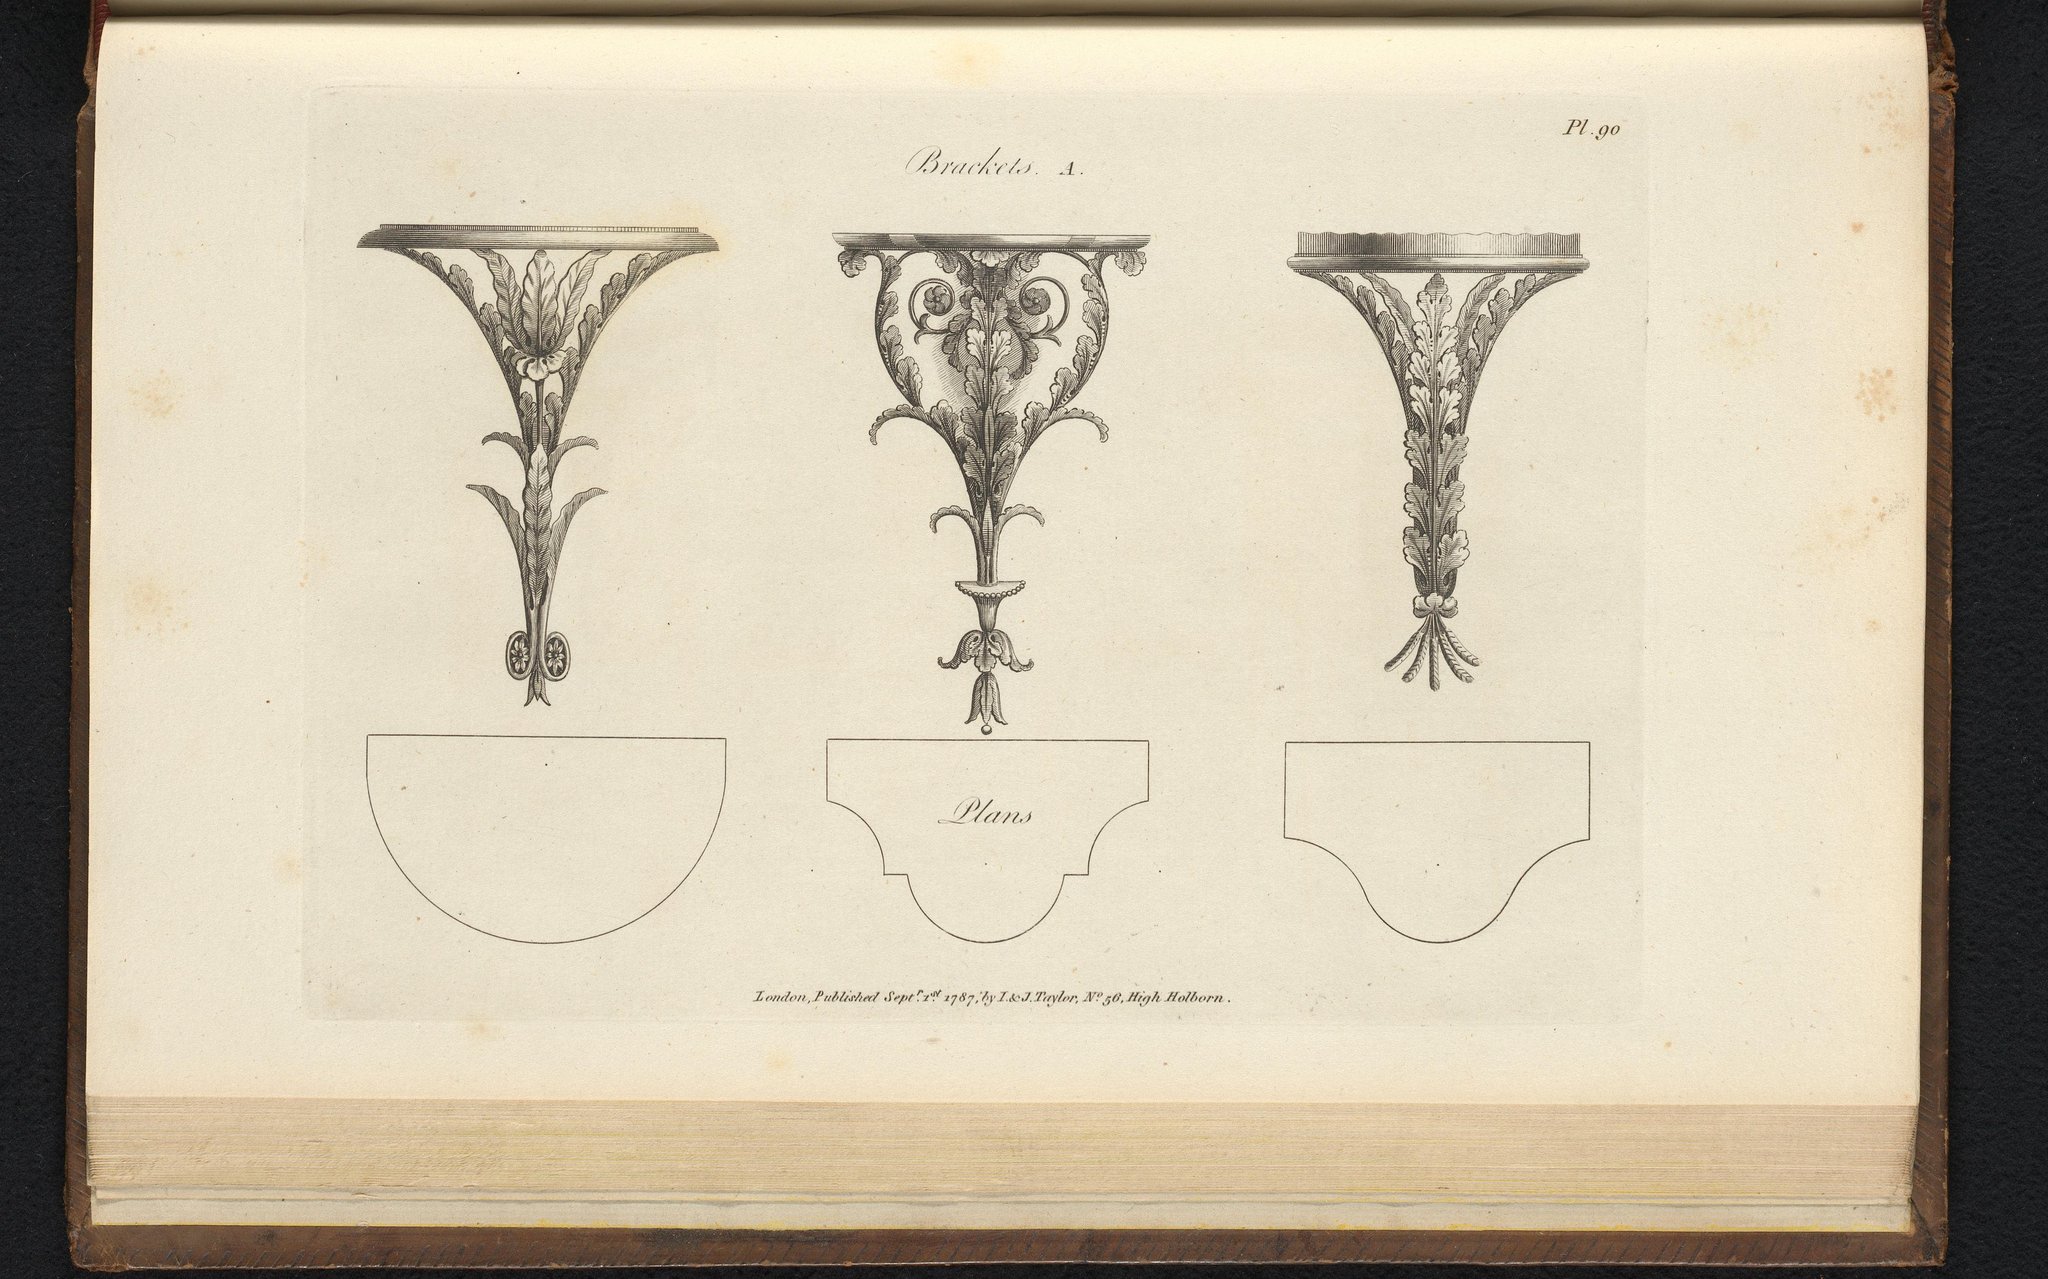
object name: page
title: Brackets / Plans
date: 1787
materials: paper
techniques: engraving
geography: holborn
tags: furniture and household effects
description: Genummerd: Pl. 90. Gemerkt: A. Prent maakt deel uit van een boek.